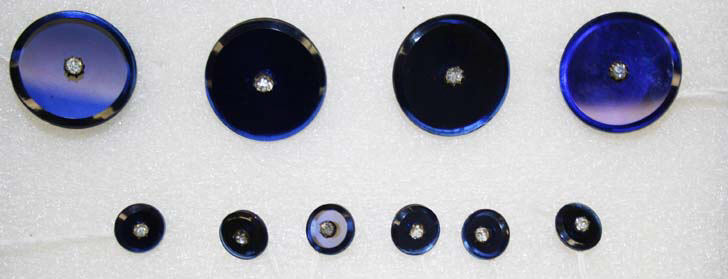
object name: button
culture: french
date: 1850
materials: glass